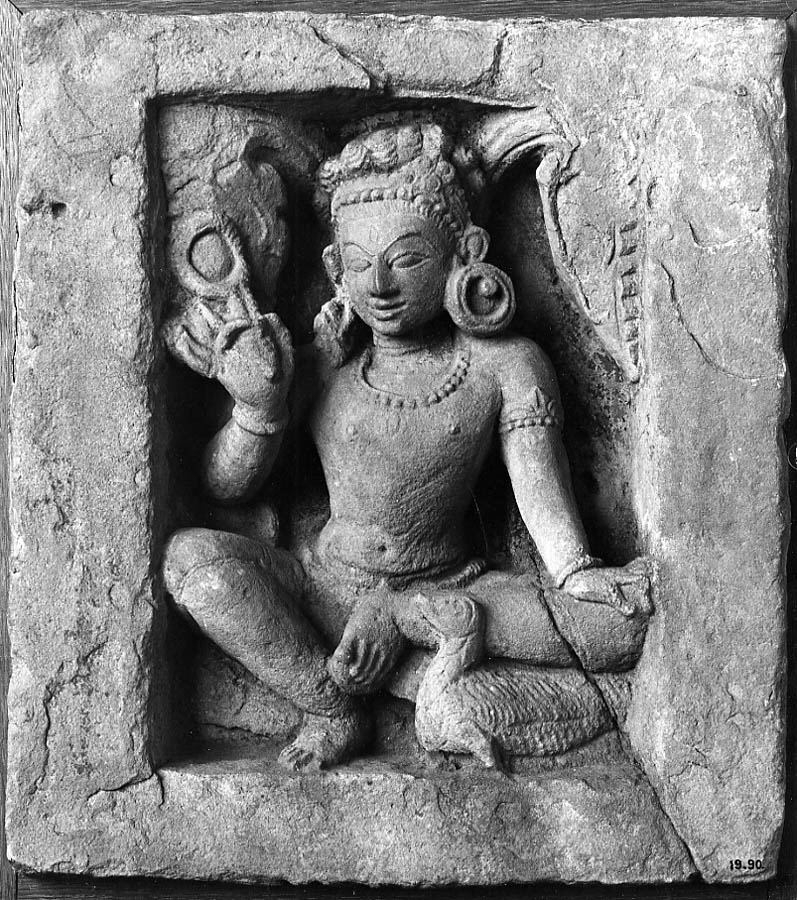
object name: figure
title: Varuna Holding a Noose and Riding a Swan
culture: indian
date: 501-800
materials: stone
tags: post-gupta,swans